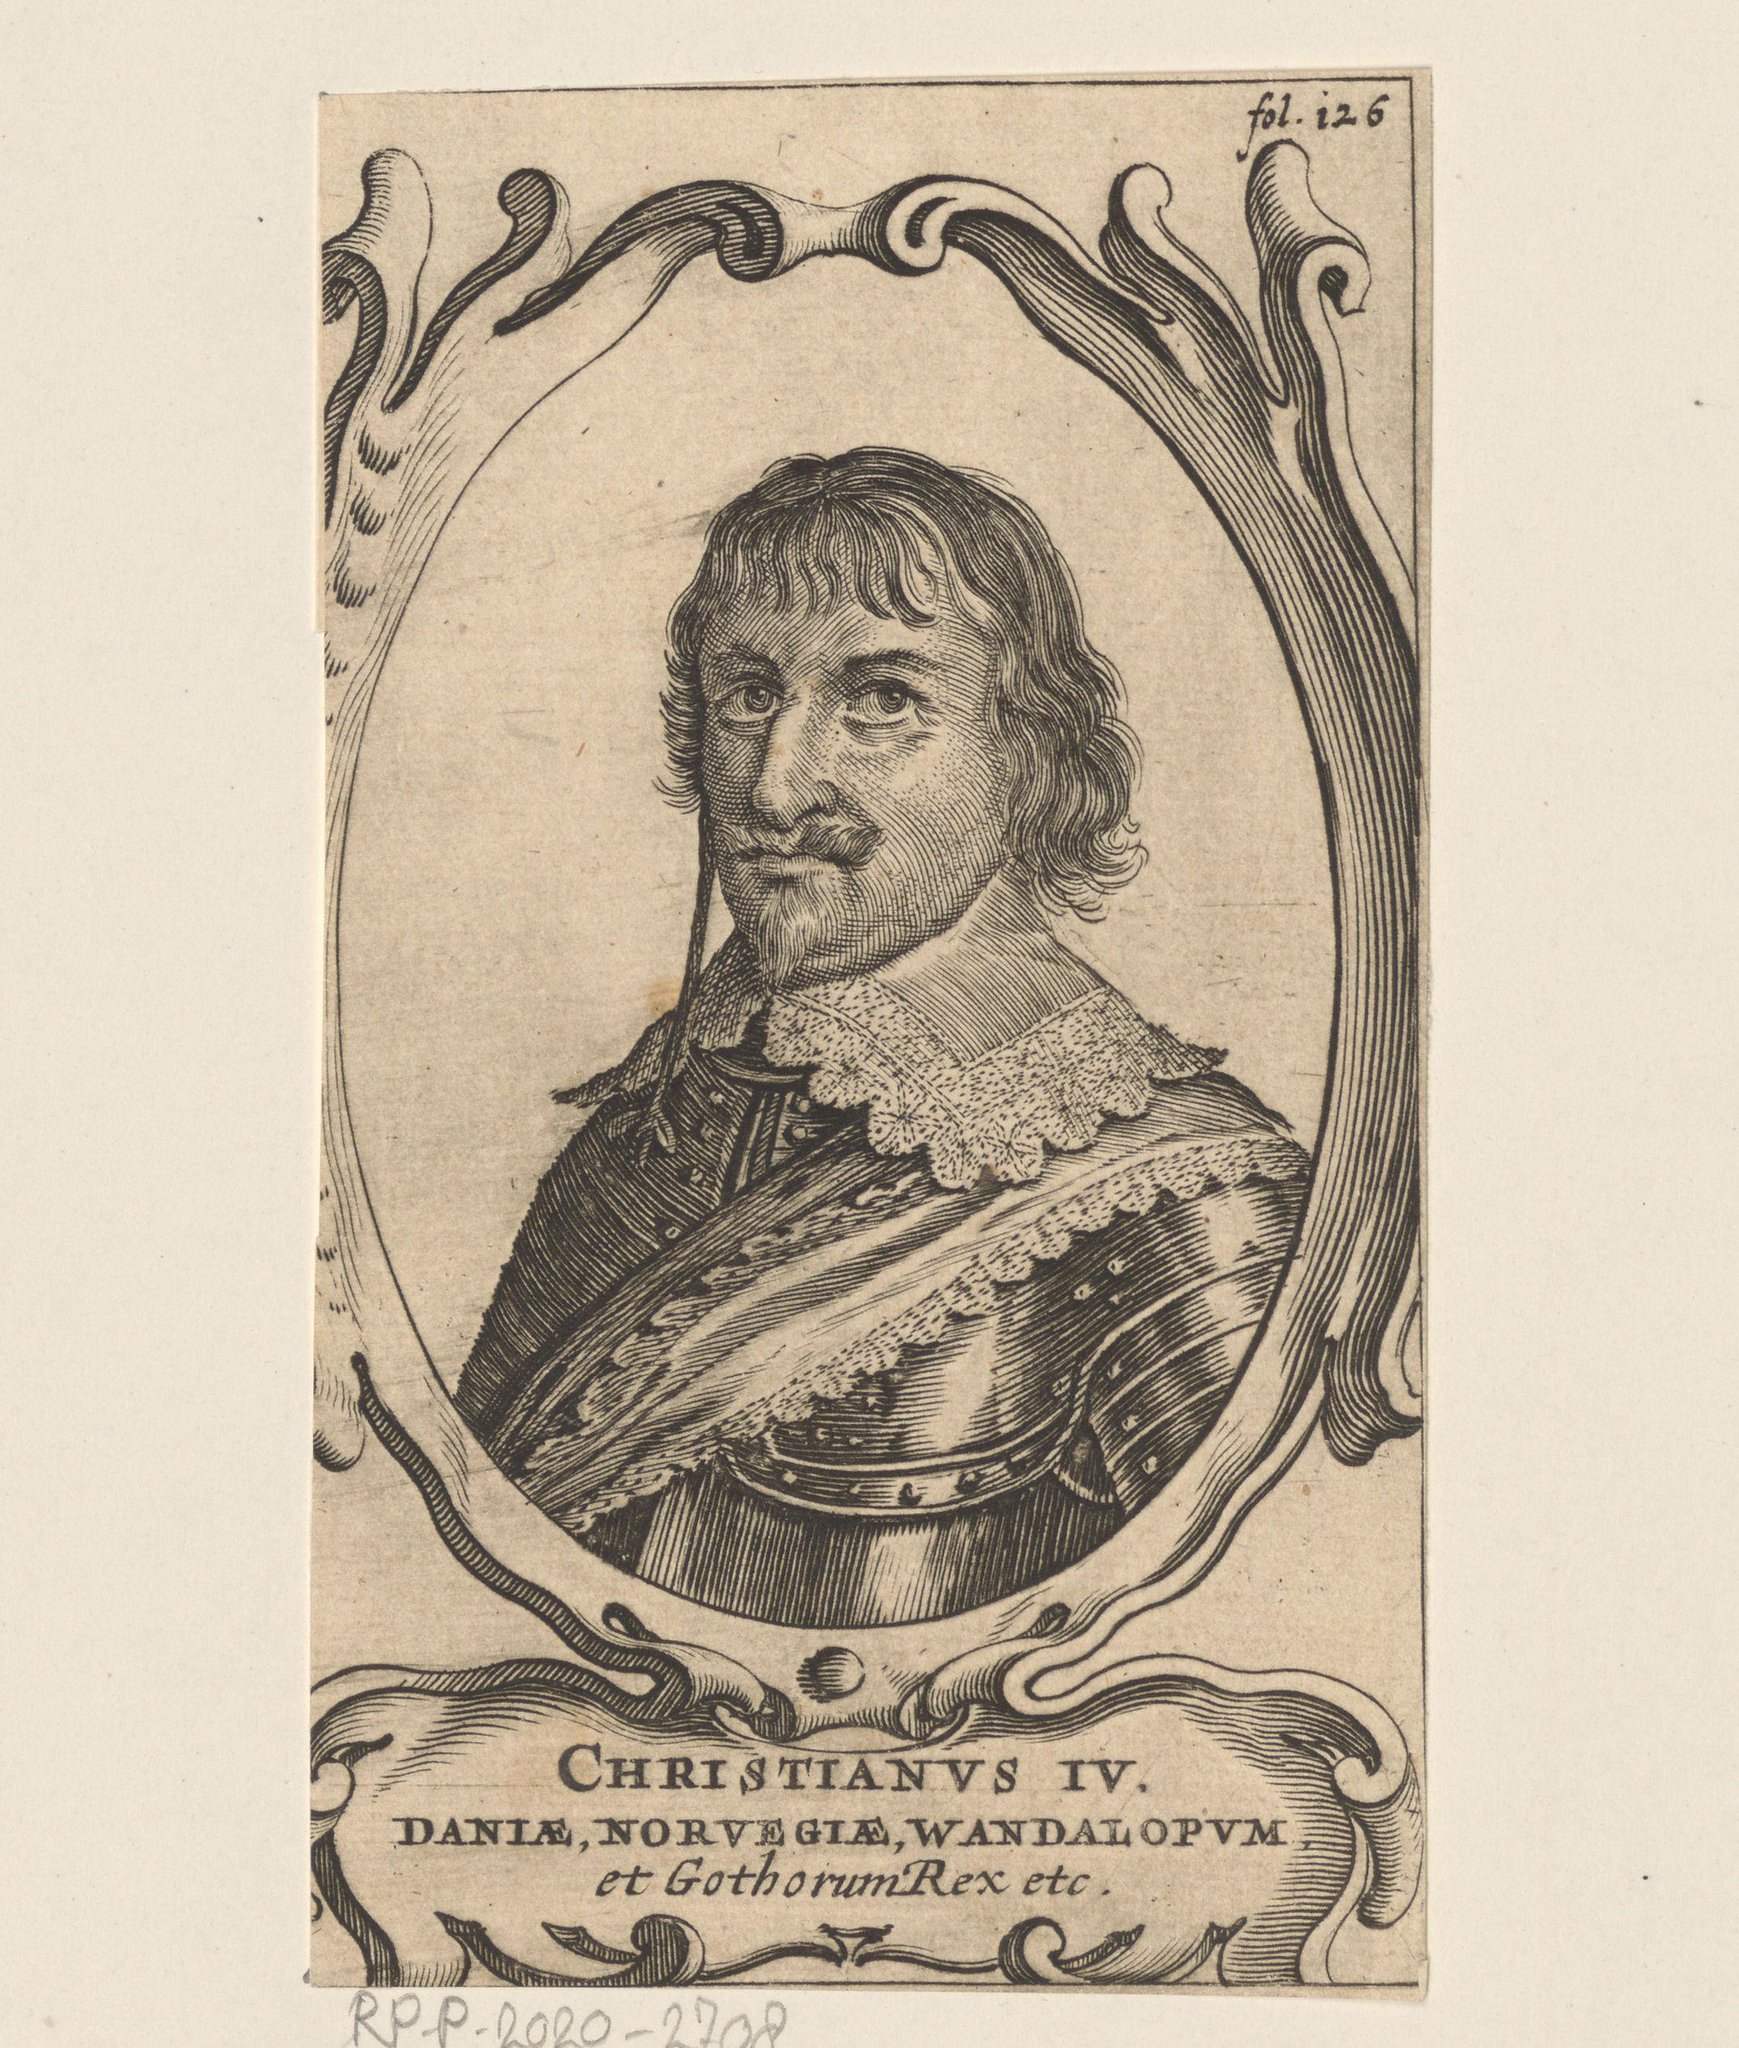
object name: print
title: Portret van Christiaan IV, koning van Denemarken en Noorwegen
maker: Anonymous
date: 1656-1666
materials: paper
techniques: engraving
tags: copenhagen (city), christiaan iv (koning van denemarken en noorwegen), historical persons, king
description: Prent waarschijnlijk uit: Brachelius, Johannes Adolphus. Historia nostri temporis, dat is geschiedenis onses tijts (…). Rotterdam: Andries van Hoogenhuysen, 1656. Prent ook gebruikt in latere edities (1659, 1666).